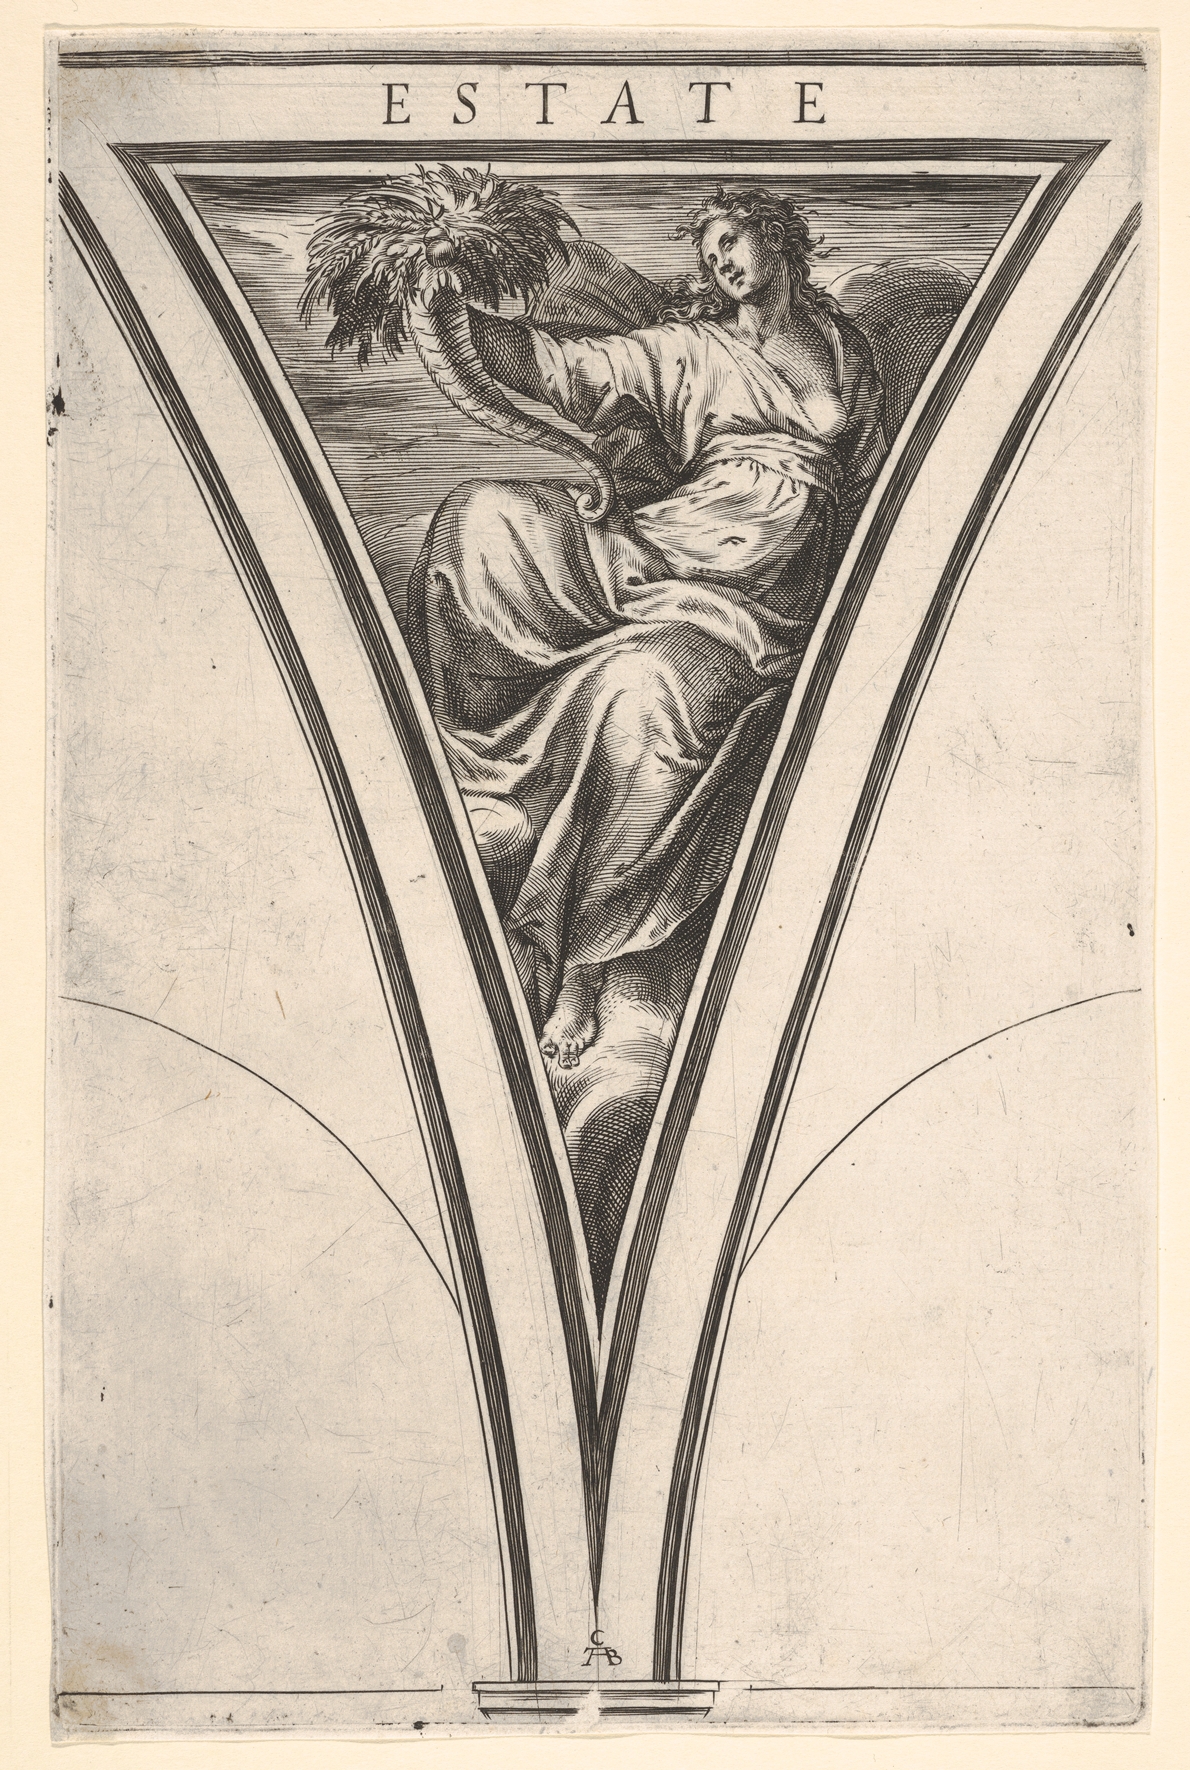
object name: print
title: Summer (Estate), represented as a robed woman bearing a horn of plenty, a spandrel-shaped composition from "The Four Seasons"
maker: cherubino alberti (zaccaria mattia)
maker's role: artist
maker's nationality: italian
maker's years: 1553-1615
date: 1570-1615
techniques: engraving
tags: women